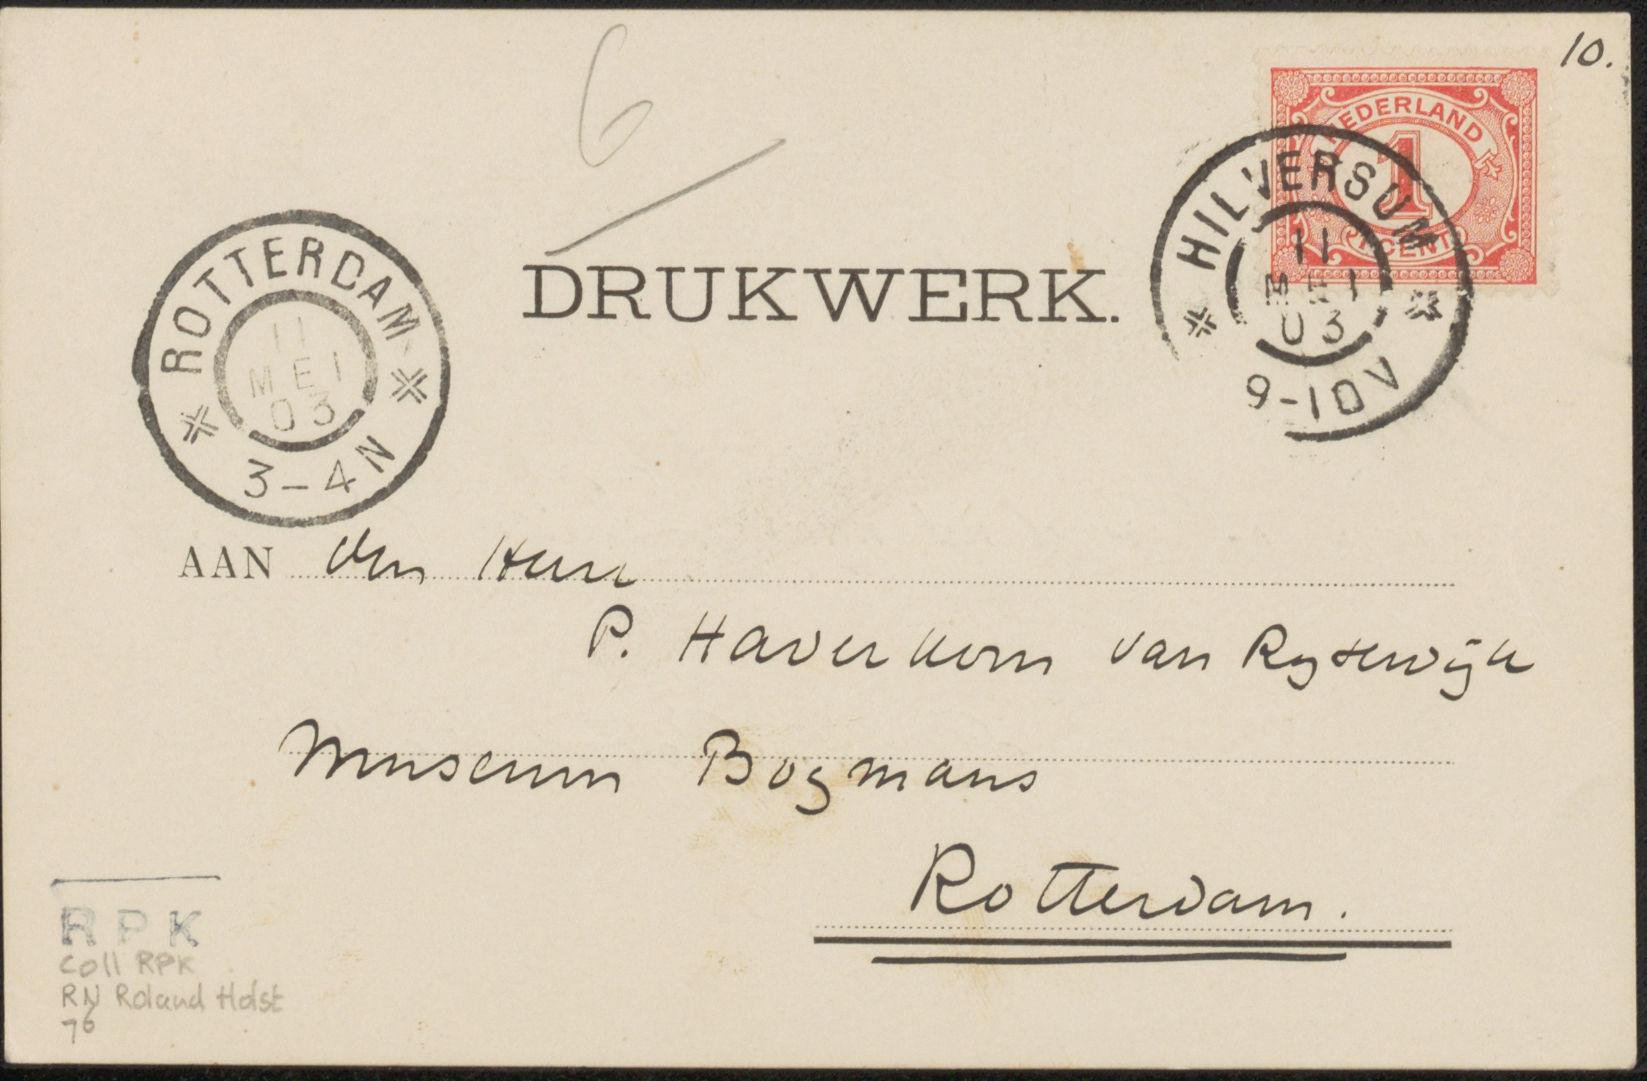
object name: postcard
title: Briefkaart aan Pieter Haverkorn van Rijsewijk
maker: richard nicolaüs roland holst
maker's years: 1868-1938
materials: cardboard, ink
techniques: pen, writing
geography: hilversum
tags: pieter haverkorn van rijsewijk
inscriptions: collector's mark: ‘RPK’